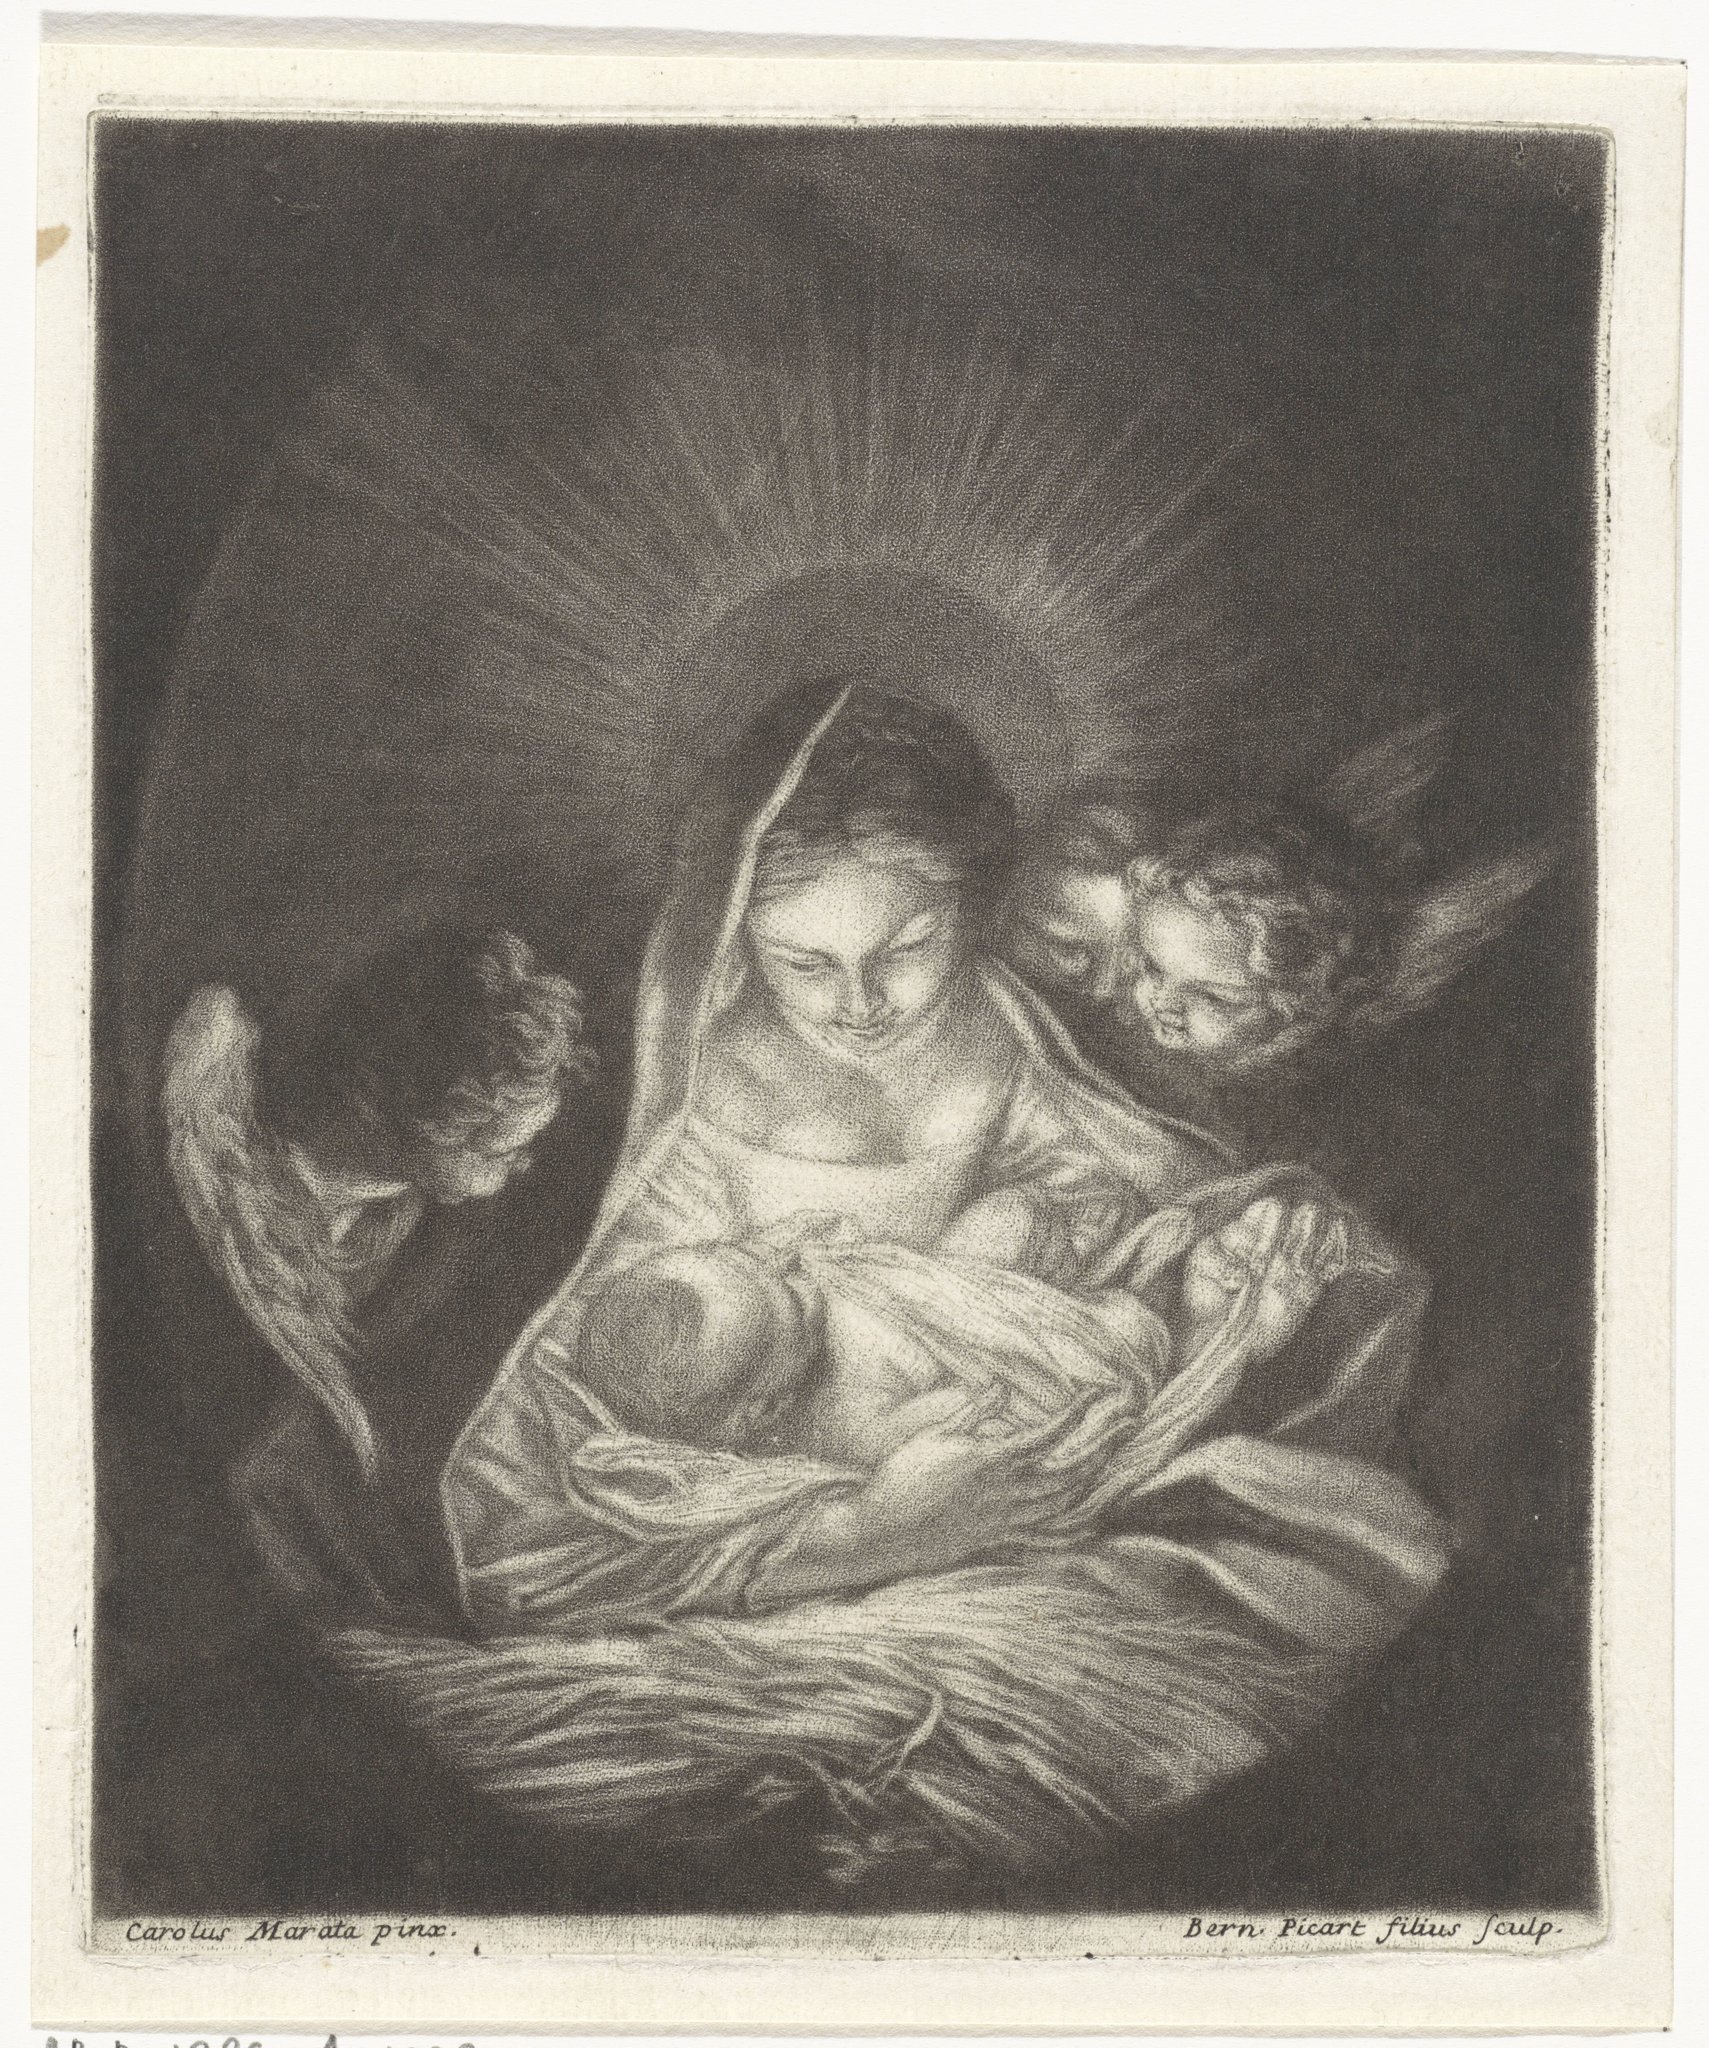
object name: print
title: Maria met Kind, omringd door engelen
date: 1683-1733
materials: paper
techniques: engraving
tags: madonna: i.e. mary with the christ-child, angels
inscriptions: collector's mark: Lugt 2228